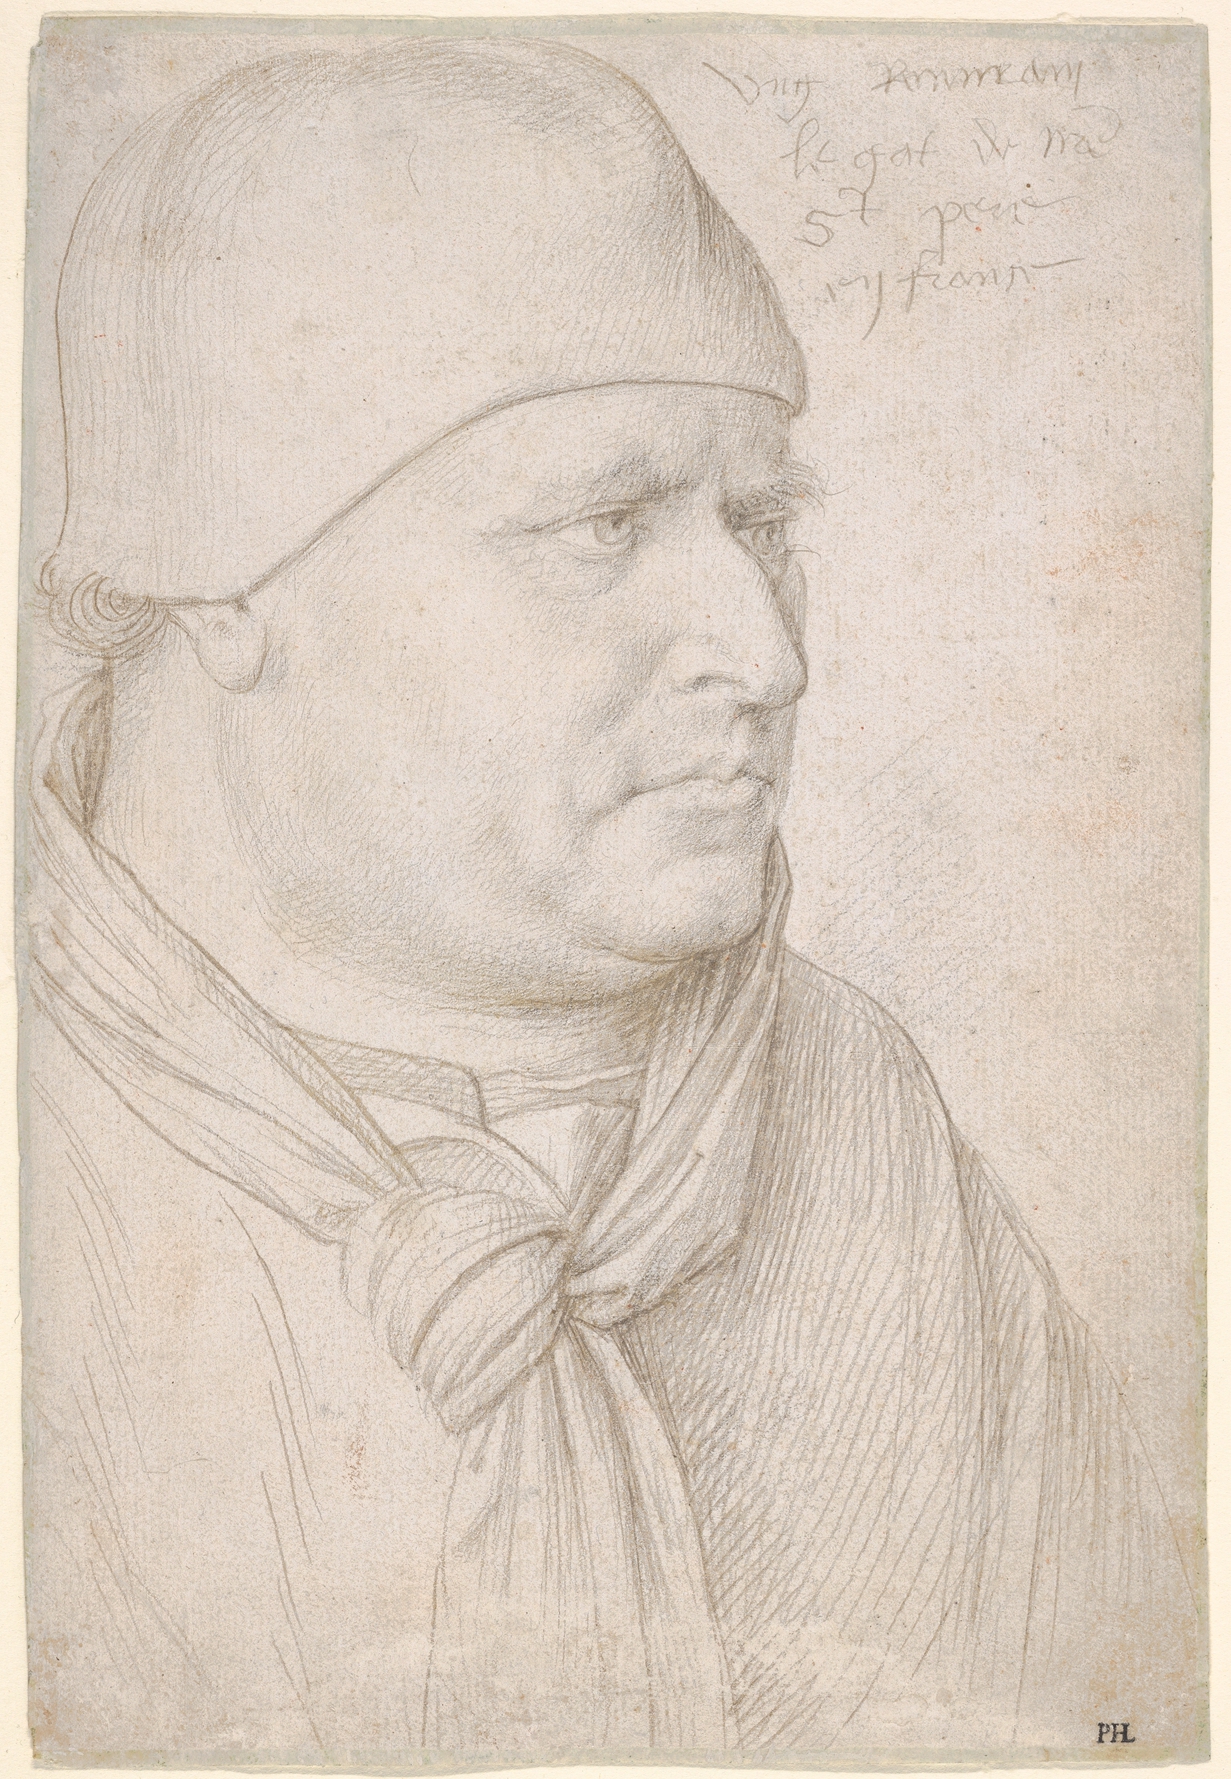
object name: drawing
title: Portrait of Alain de Coëtivy (1407–1474)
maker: jean fouquet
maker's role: artist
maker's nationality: french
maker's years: 1425-1478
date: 1451-1455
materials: chalk, paper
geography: france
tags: men,portraits